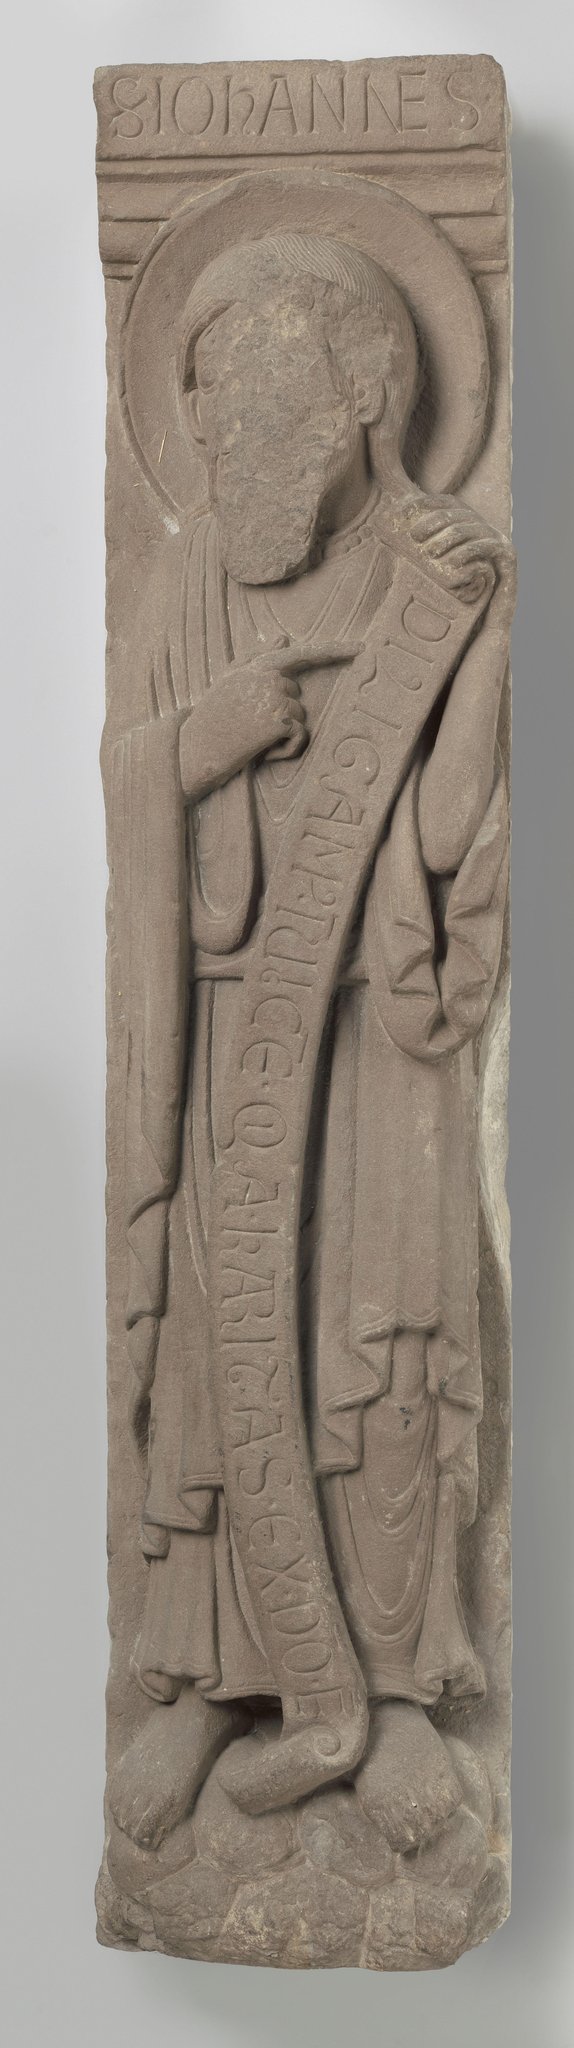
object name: stile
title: Relief with St John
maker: Anonymous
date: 1150-1170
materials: stone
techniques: carved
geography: maastricht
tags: sint odiliënberg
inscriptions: inscription, on the banderol: ‘DILIGAM[US]. I[N]VICE[M]. Q[U]IA. KARITAS. EX. D[E]O. E[ST]’, inscription, on the profiled border above: ‘S. IOHANNES’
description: Pilaster. St James. Mosan sandstone. Maastricht, c. 1200. Excavated in the church at St. Odiliënberg.